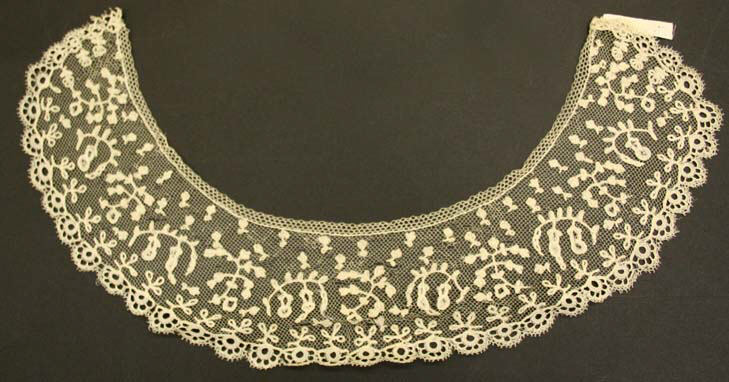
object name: collar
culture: british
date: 1801-1900